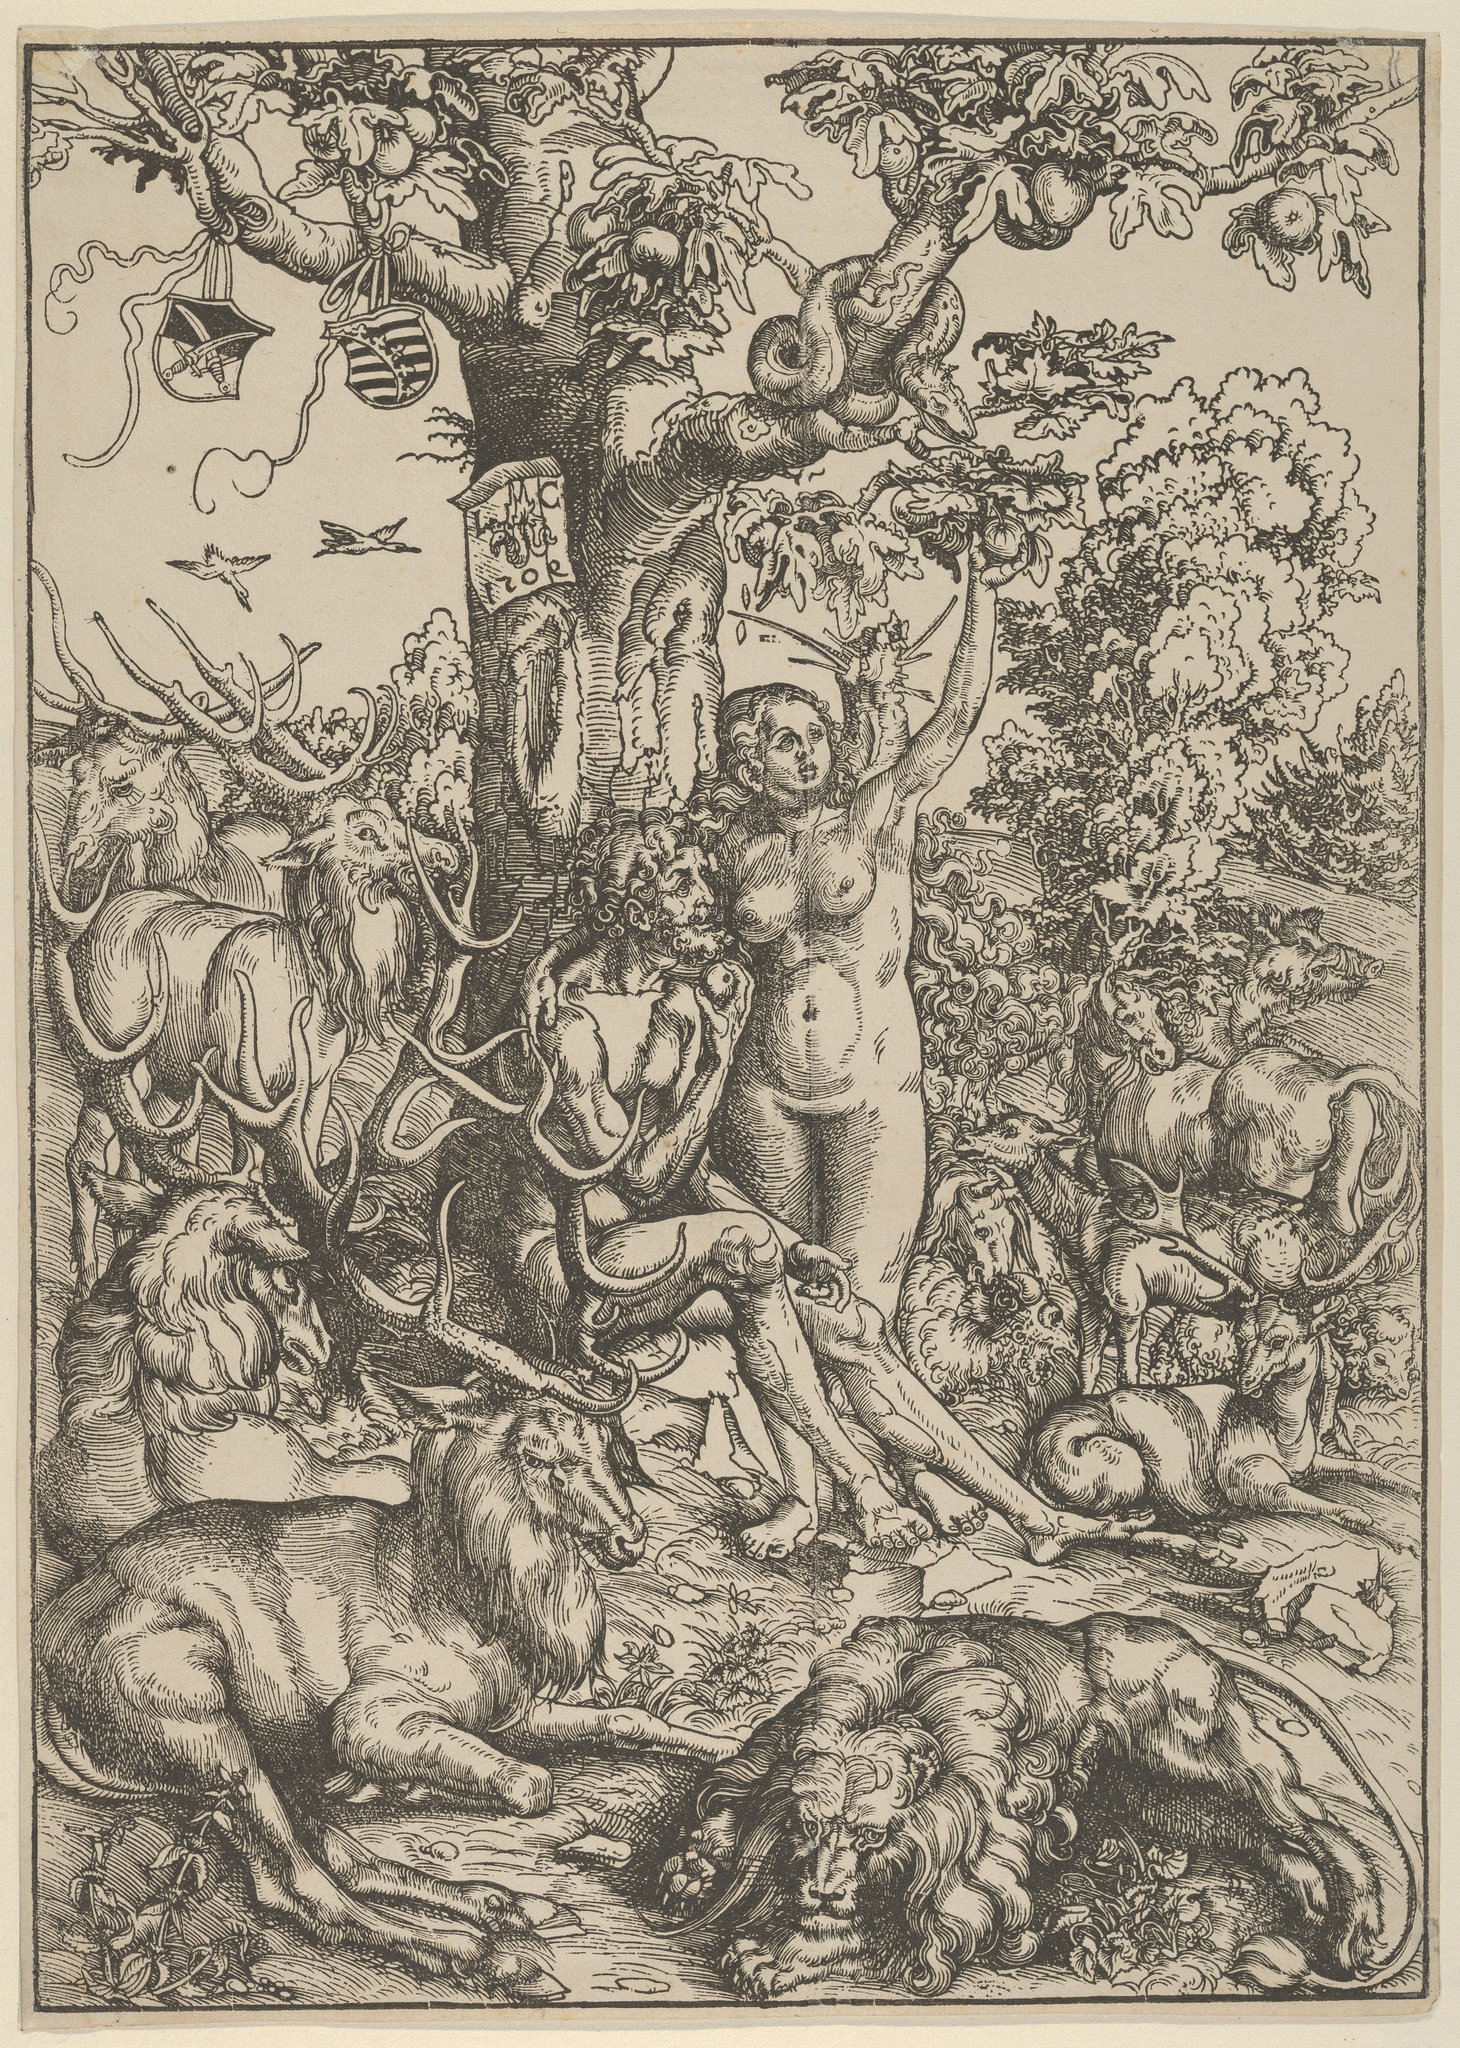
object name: print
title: Adam and Eve in Paradise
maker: lucas cranach the elder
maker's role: artist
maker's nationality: german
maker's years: 1472-1553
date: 1509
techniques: woodcut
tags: deer,snakes,adam,eve